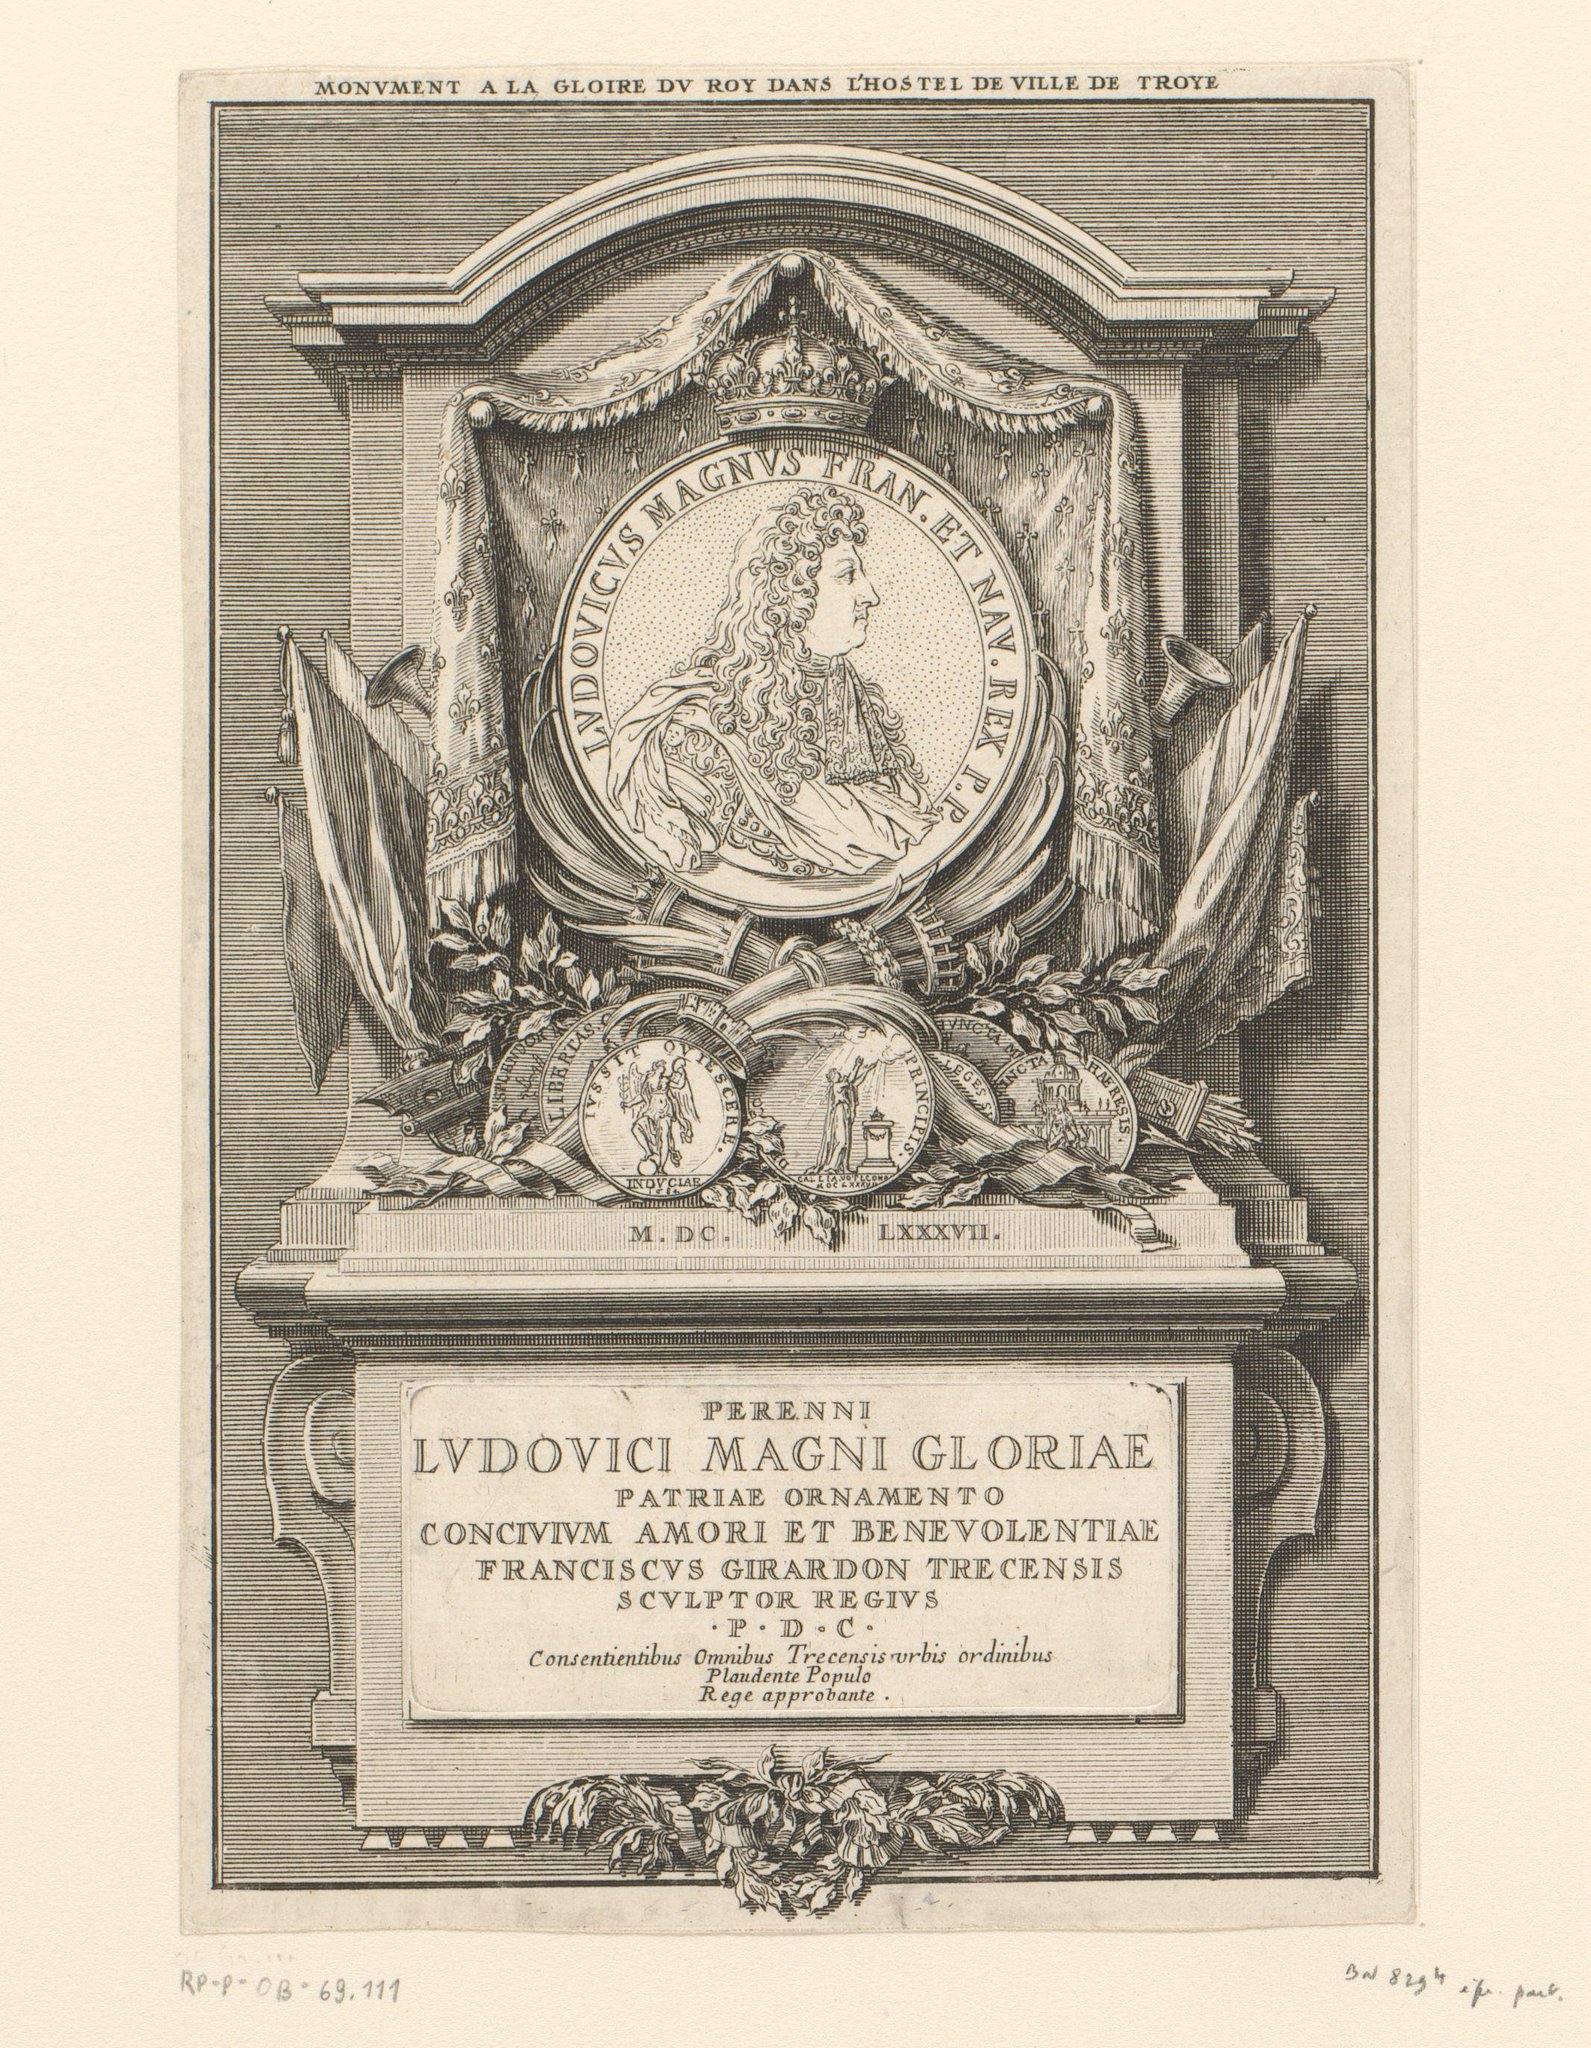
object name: print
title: Monument ter ere van Lodewijk XIV in het stadhuis van Troyes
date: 1687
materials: paper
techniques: etching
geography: france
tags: lodewijk xiv (koning van frankrijk), ornament ~ medallion, monument, statue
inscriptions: date